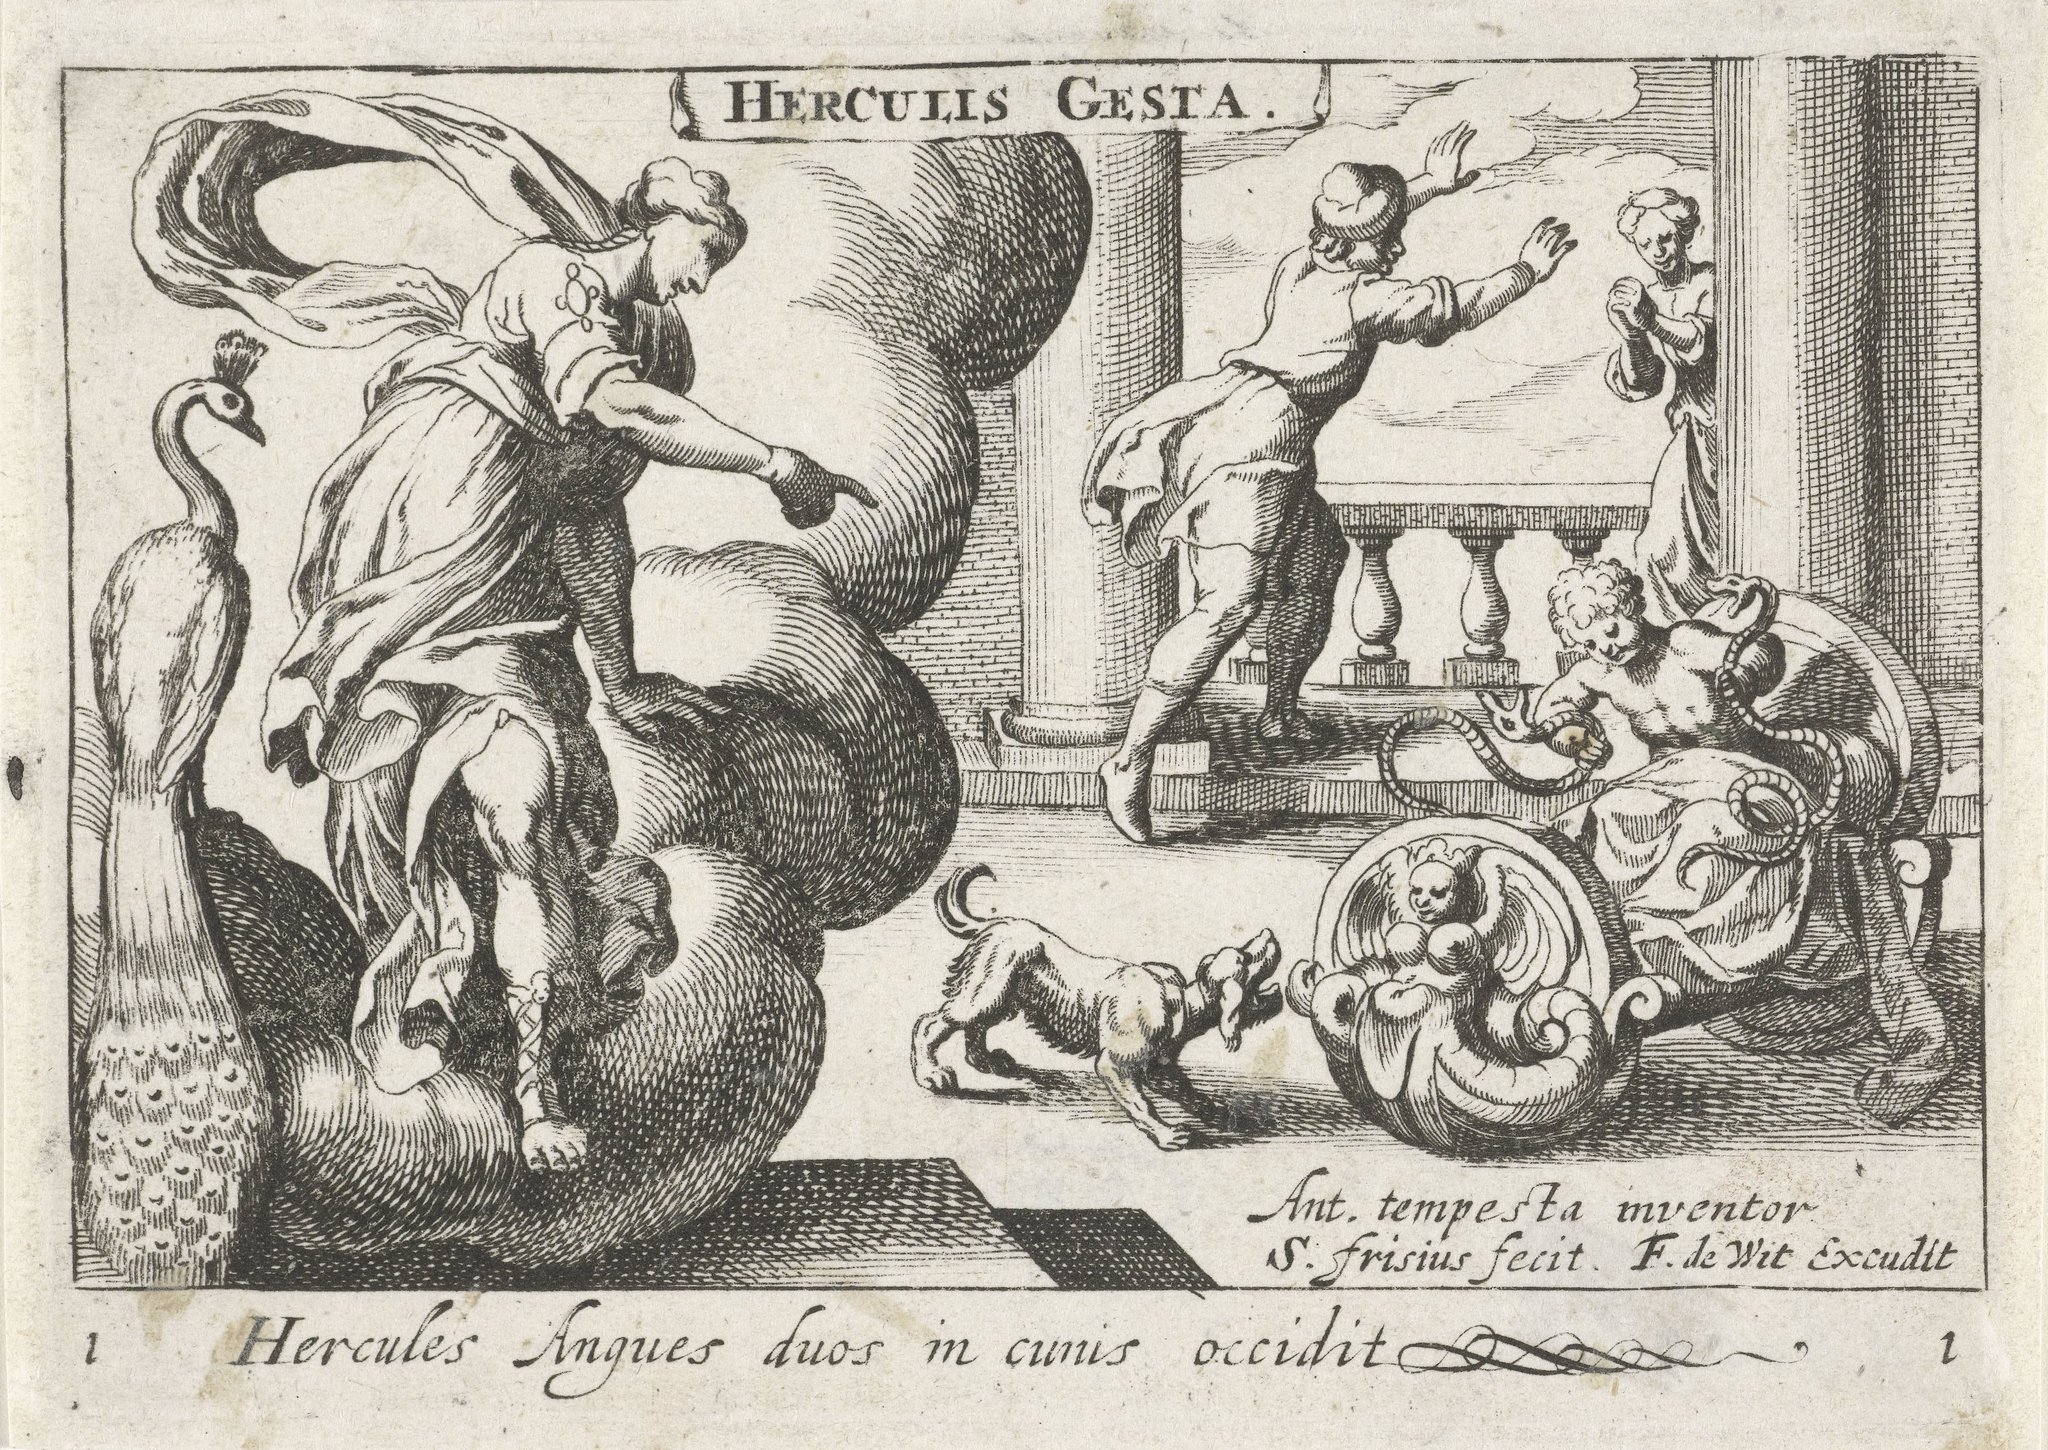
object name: print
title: Herculische thema's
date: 1610-1652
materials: paper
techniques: etching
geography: northern netherlands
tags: hercules strangles two serpents in his cradle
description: De jonge Hercules zit rechtop in zijn wieg en wurgt twee slangen. Links slaat Juno de gebeurtenis vanaf een wolk gade.